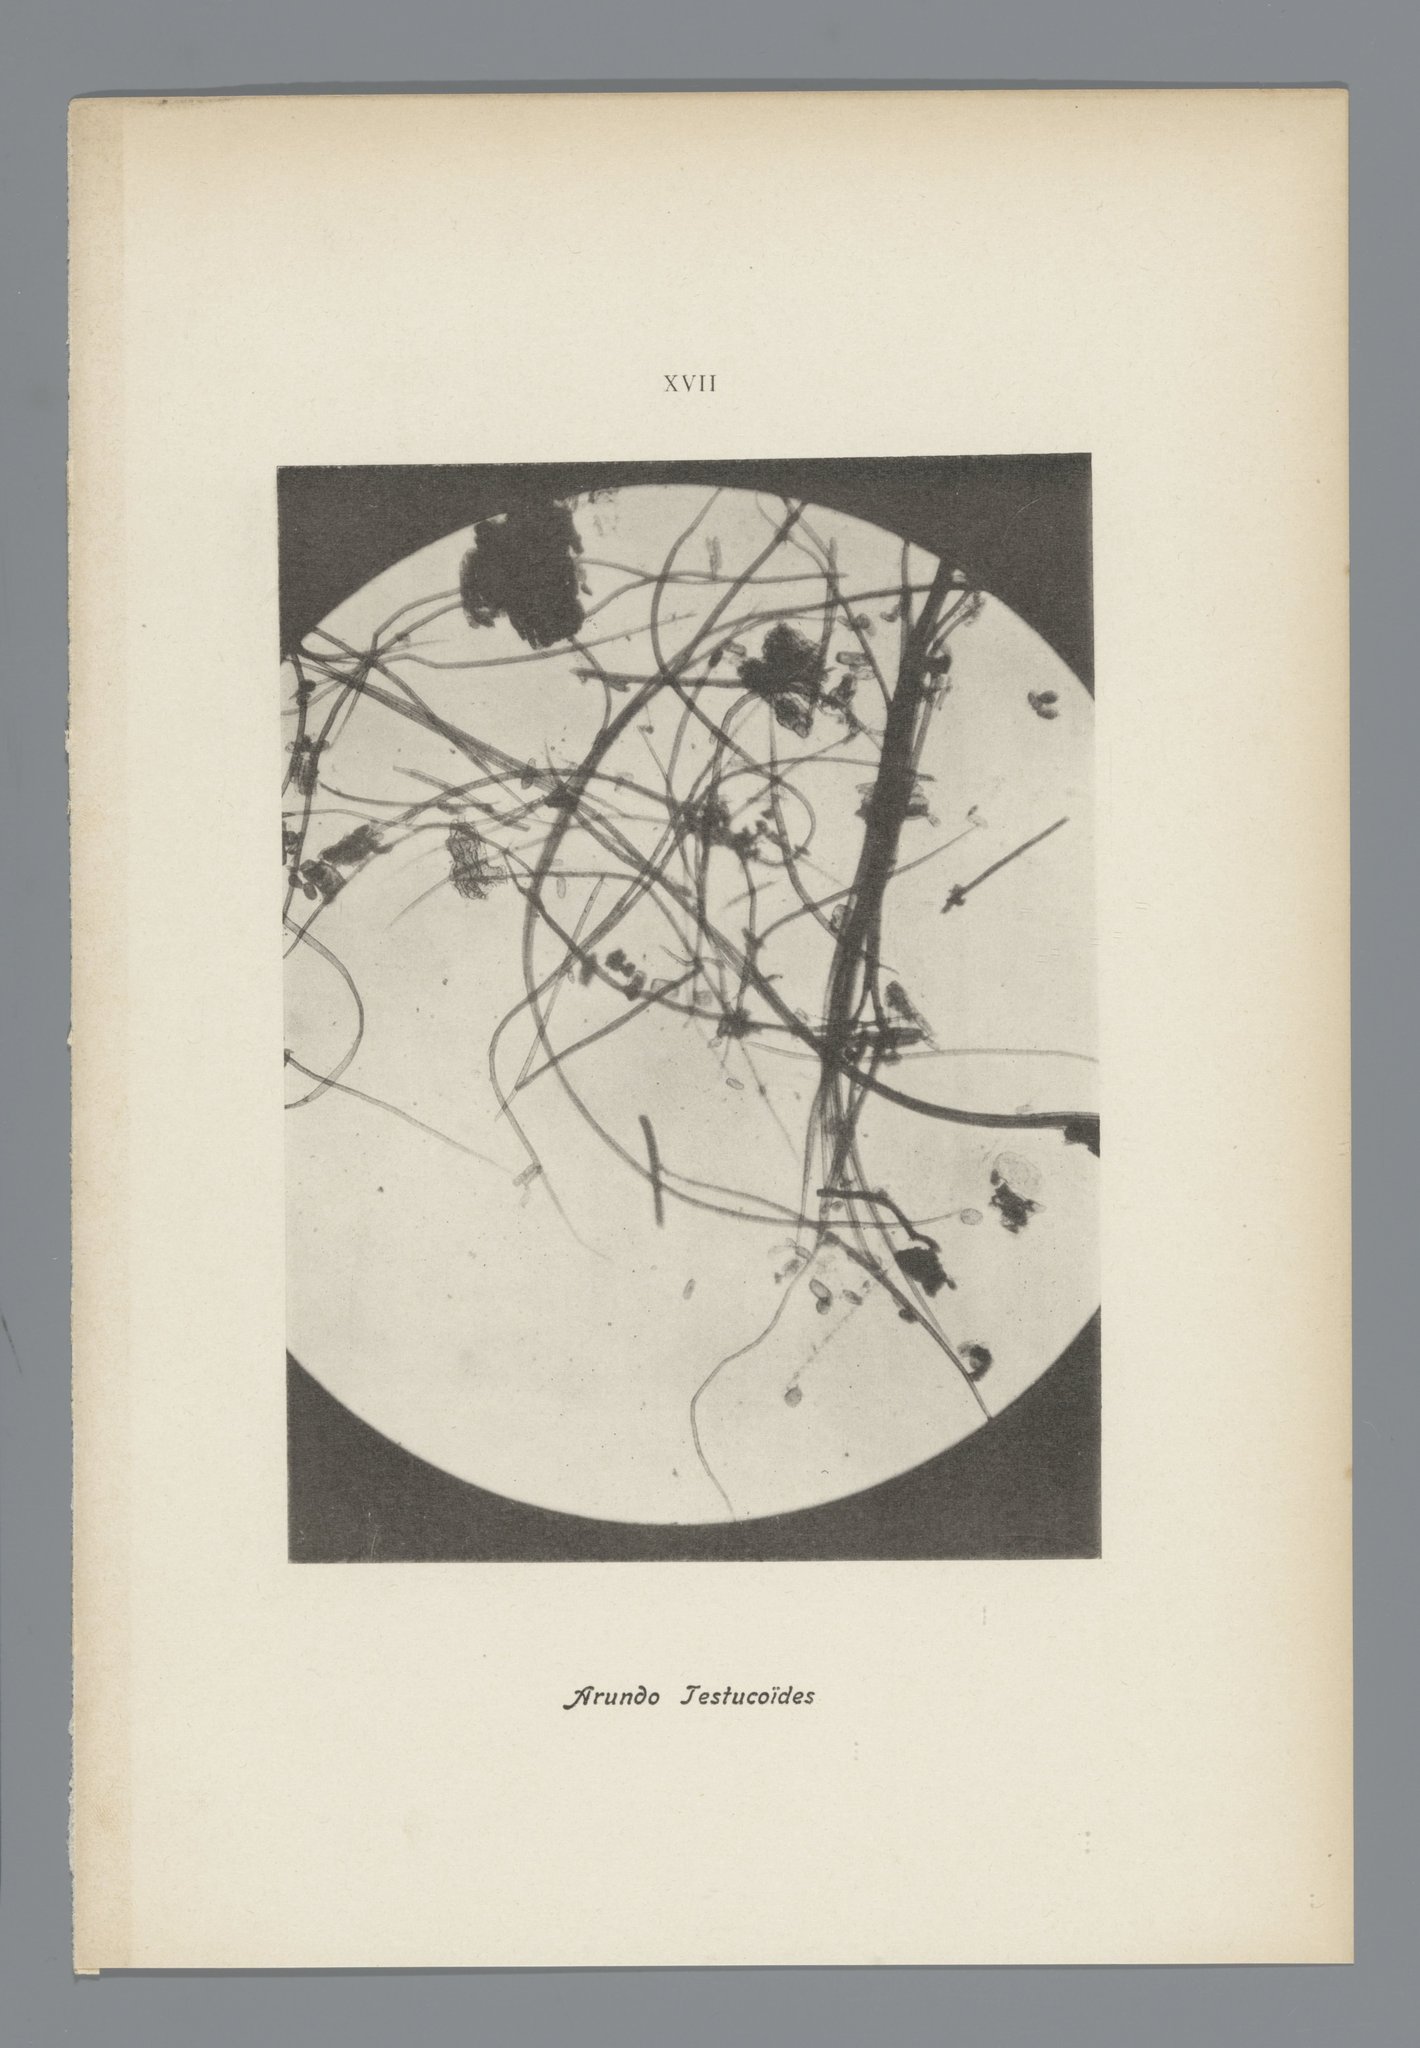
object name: photograph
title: XVII Arundo Testucoïdes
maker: Anonymous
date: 1900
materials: ink, paper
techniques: photograph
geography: france